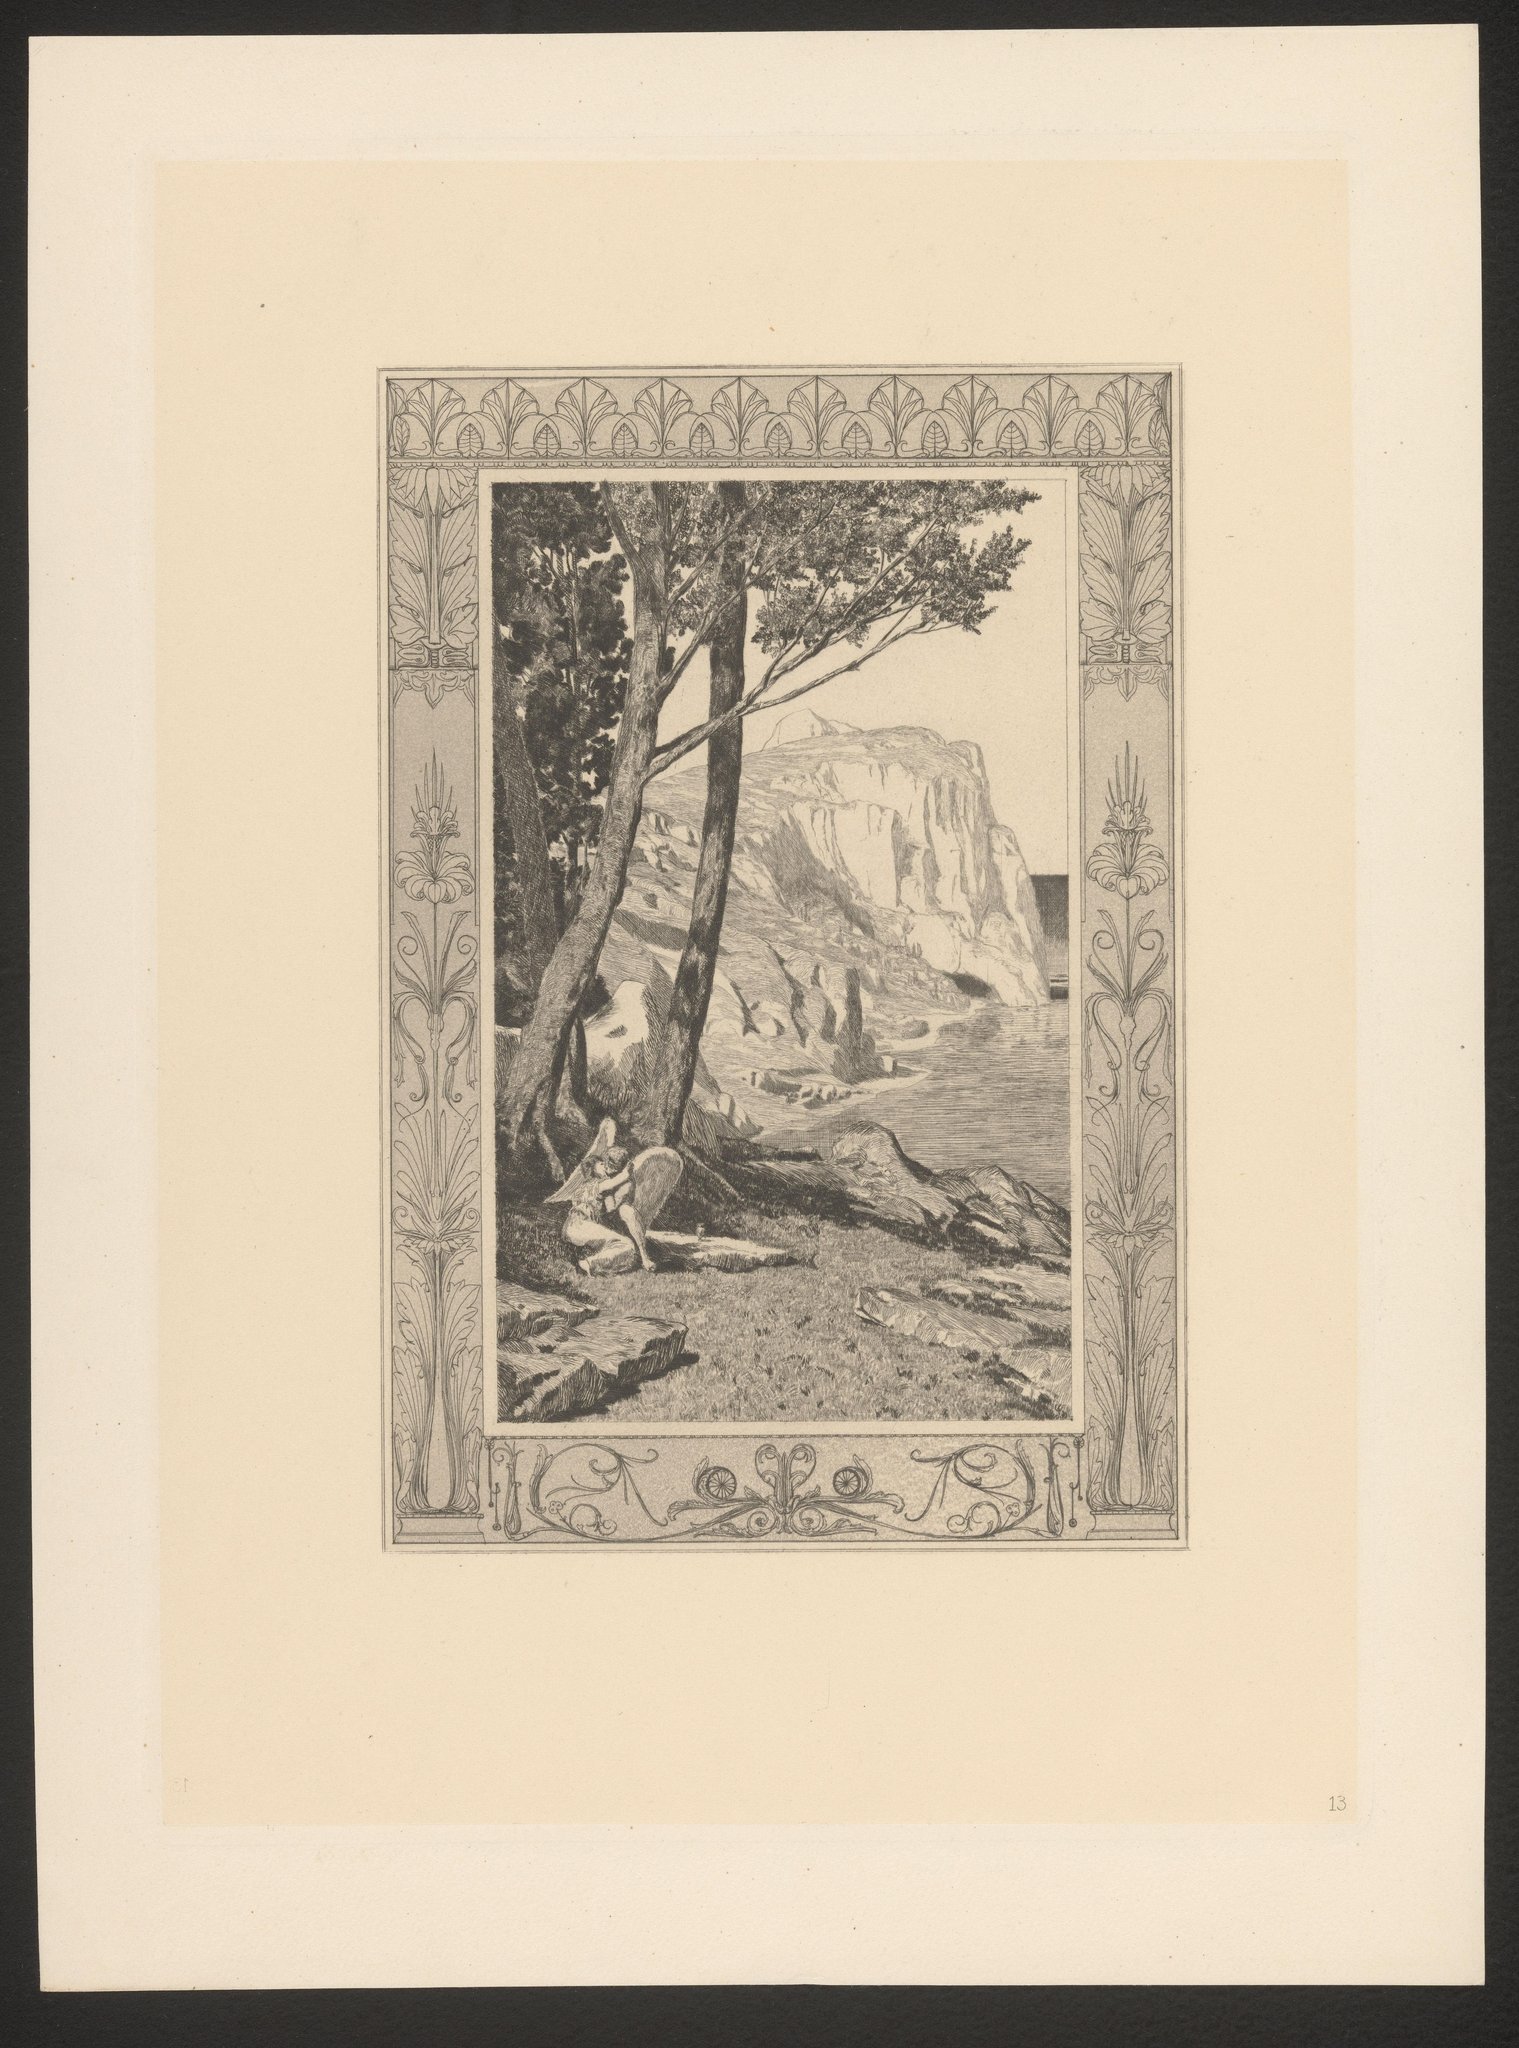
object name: print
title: Amor vindt Psyche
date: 1880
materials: paper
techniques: aquatint, etching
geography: nuremberg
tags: other scenes from the story of cupid and psyche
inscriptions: collector's mark: Lugt 2228